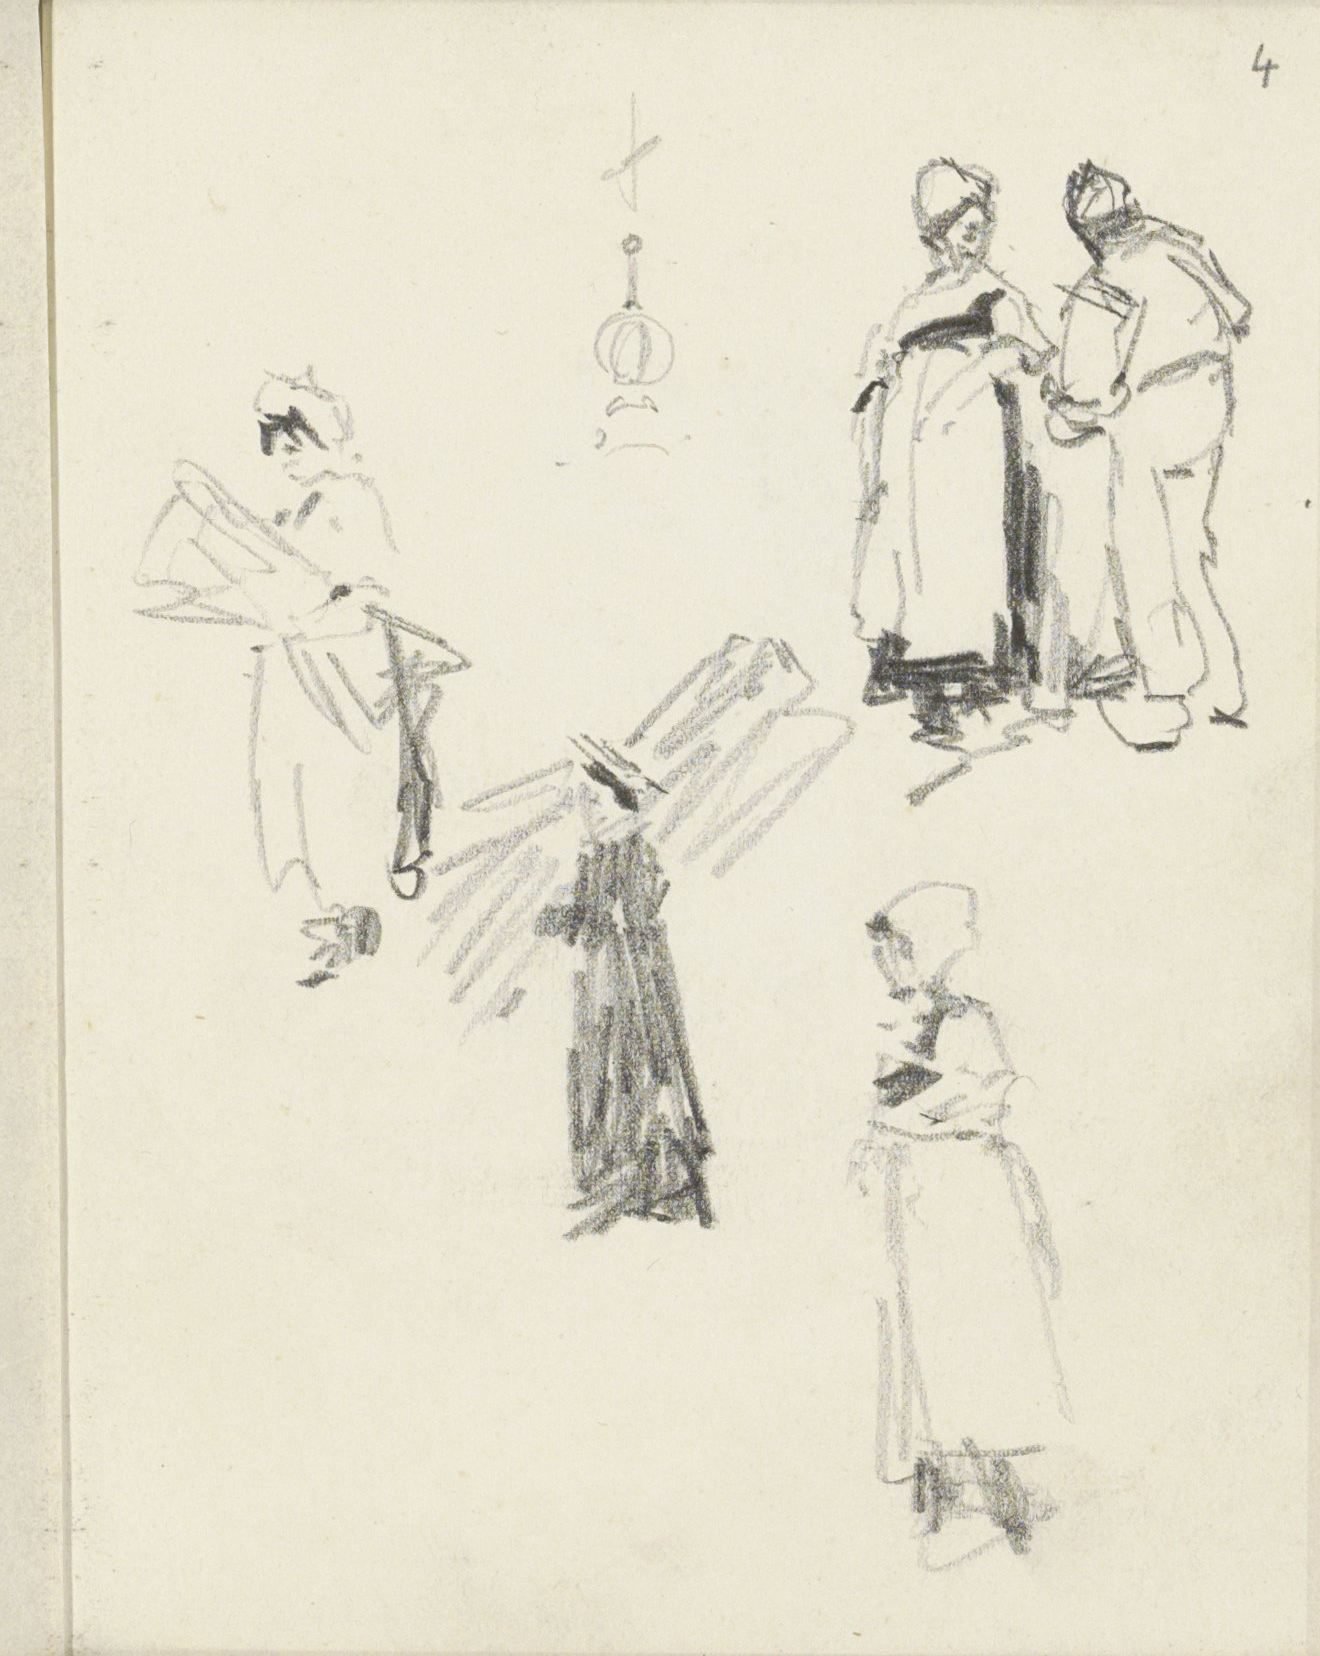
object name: sketchbook leaf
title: Torenspits en figuren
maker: alfred william rich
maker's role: draughtsman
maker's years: 1856-1921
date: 1892-1893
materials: paper, pencil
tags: europeans, parts of church exterior and annexes: spire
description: Onder andere vrouwen met schorten en een man die een bos sprokkelhout draagt. Blad 4 recto uit een schetsboek met 86 bladen.